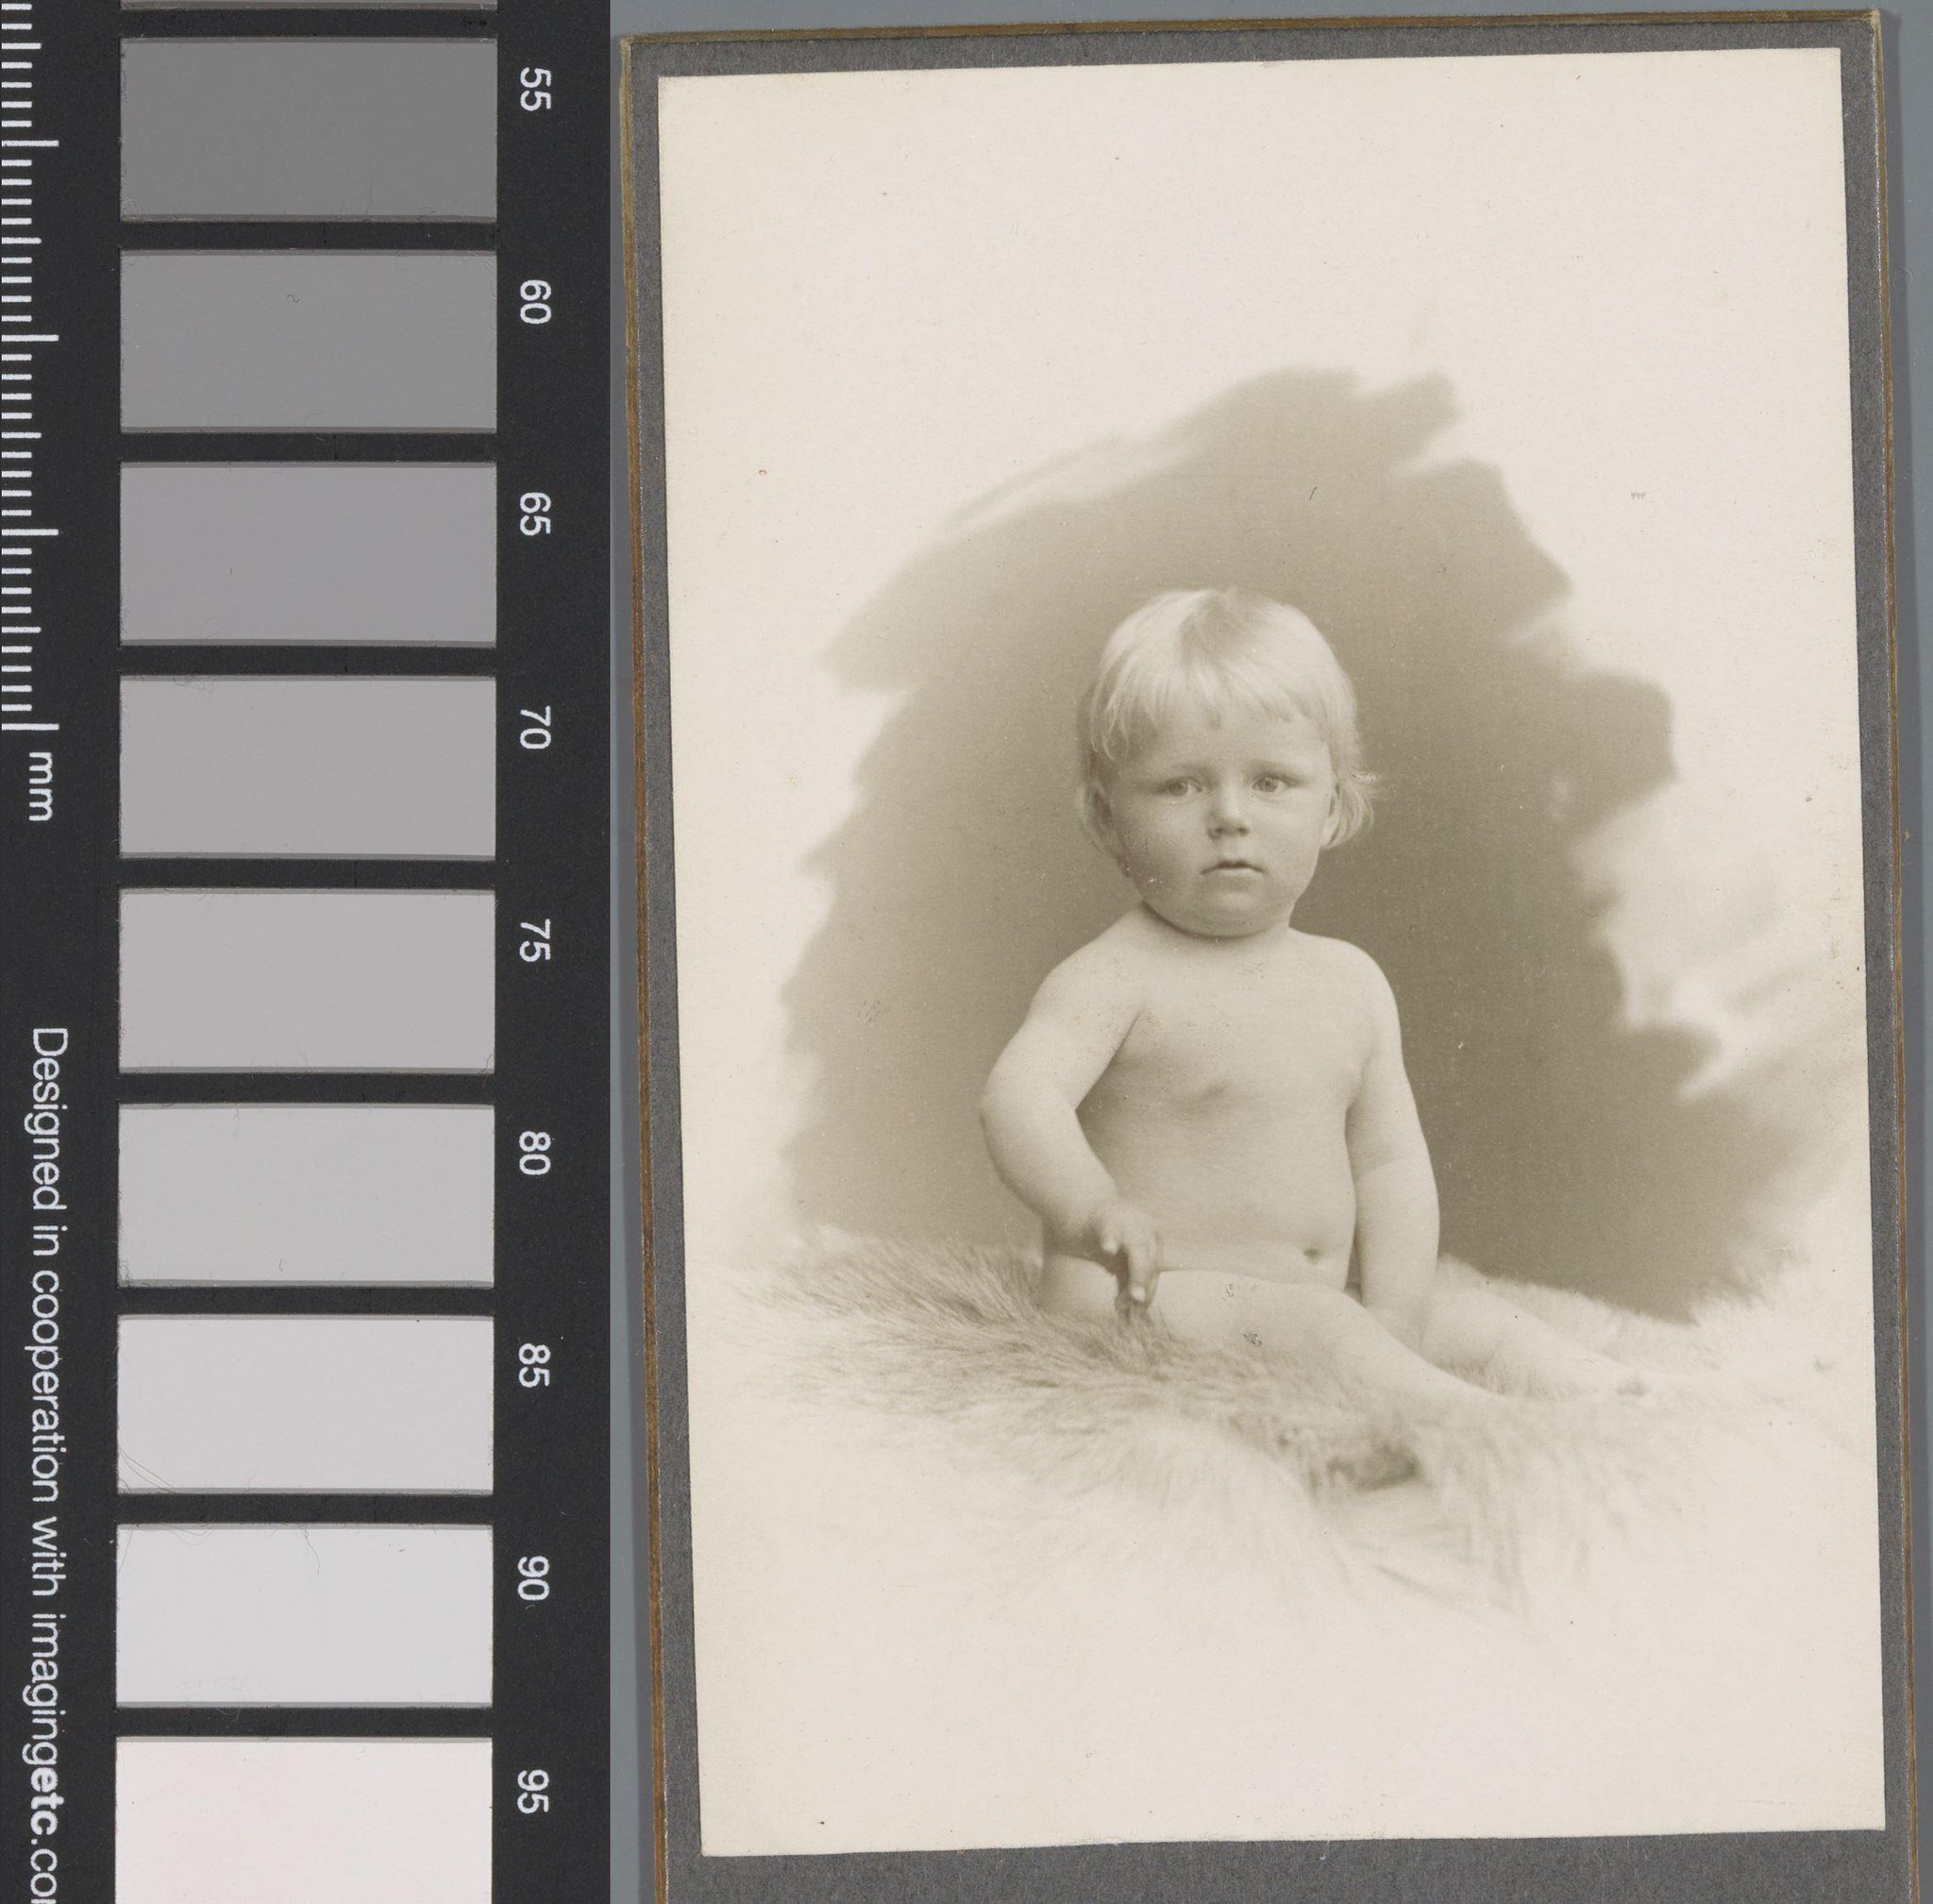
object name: carte de visite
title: Portret van een kind, aangeduid als Jacques Dain, 14 maanden oud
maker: f. vachous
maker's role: fotograaf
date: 1909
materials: cardboard, paper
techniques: albumen print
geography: montreux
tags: historical persons, infant, baby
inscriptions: inscription: ‘Jacques Dain 1909/ 14 mois.’